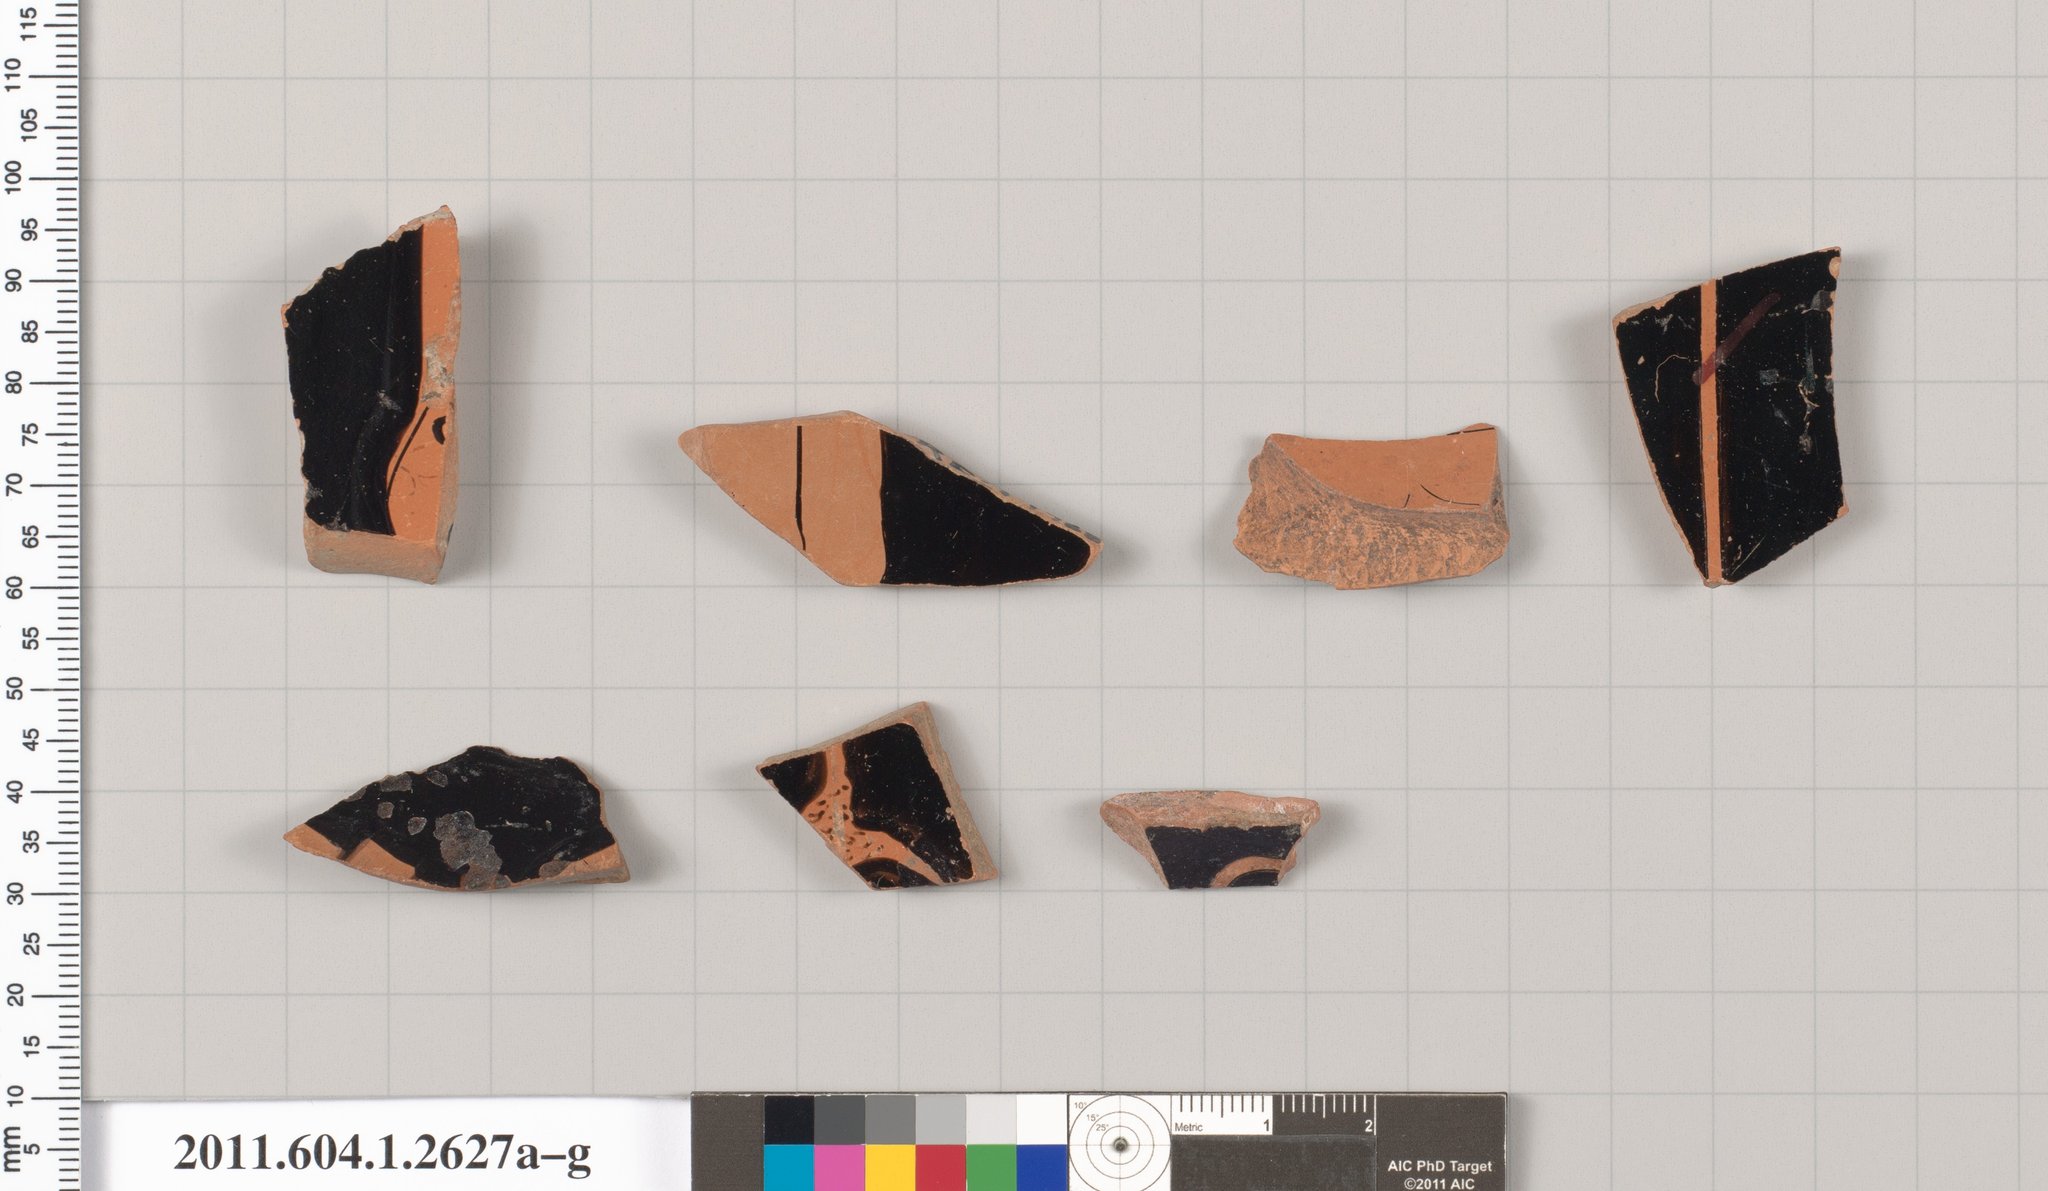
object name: kylix fragment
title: Terracotta fragments of kylikes (drinking cups)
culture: greek, attic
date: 500-401 BCE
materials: terracotta